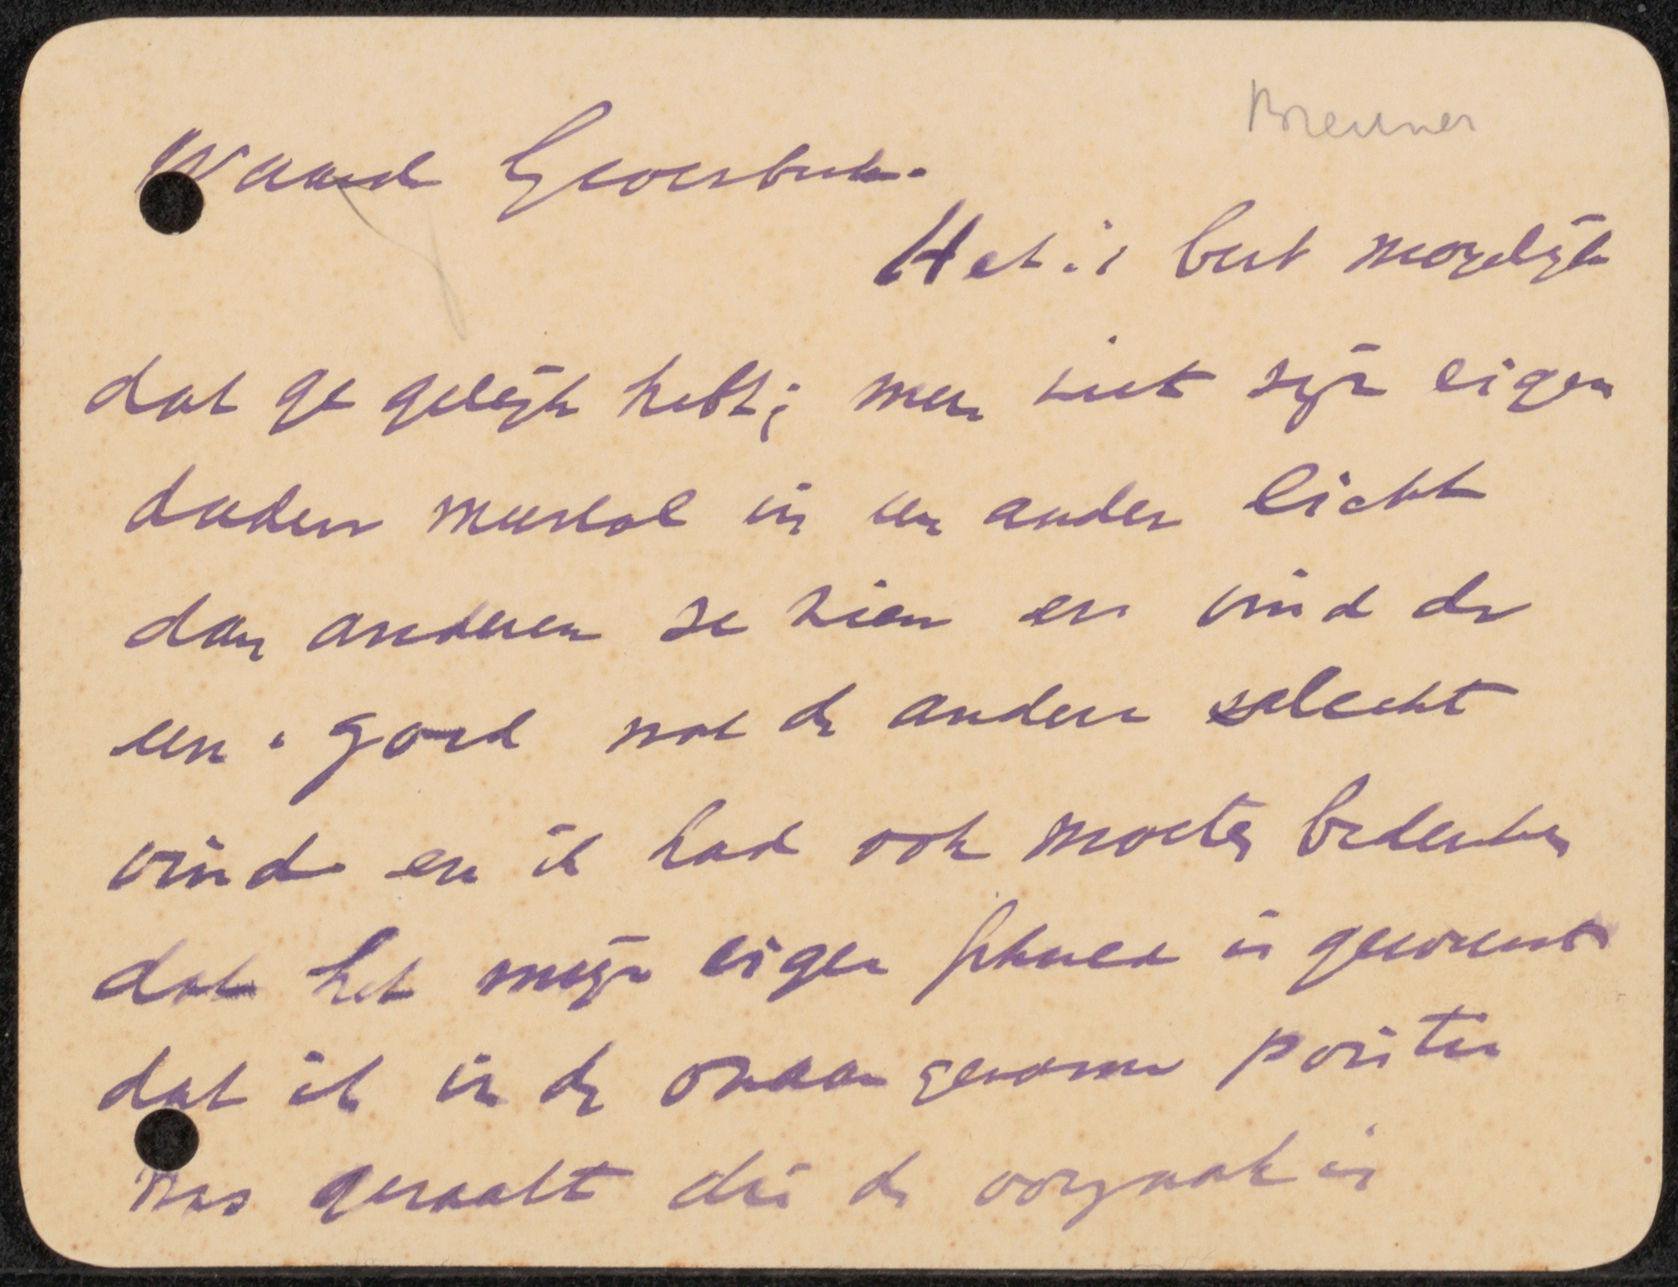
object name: letter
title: Brief aan Klaas Groesbeek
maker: george hendrik breitner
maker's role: draughtsman, painter, print maker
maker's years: 1857-1923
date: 1868-1923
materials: cardboard, ink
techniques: pen, writing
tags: klaas groesbeek